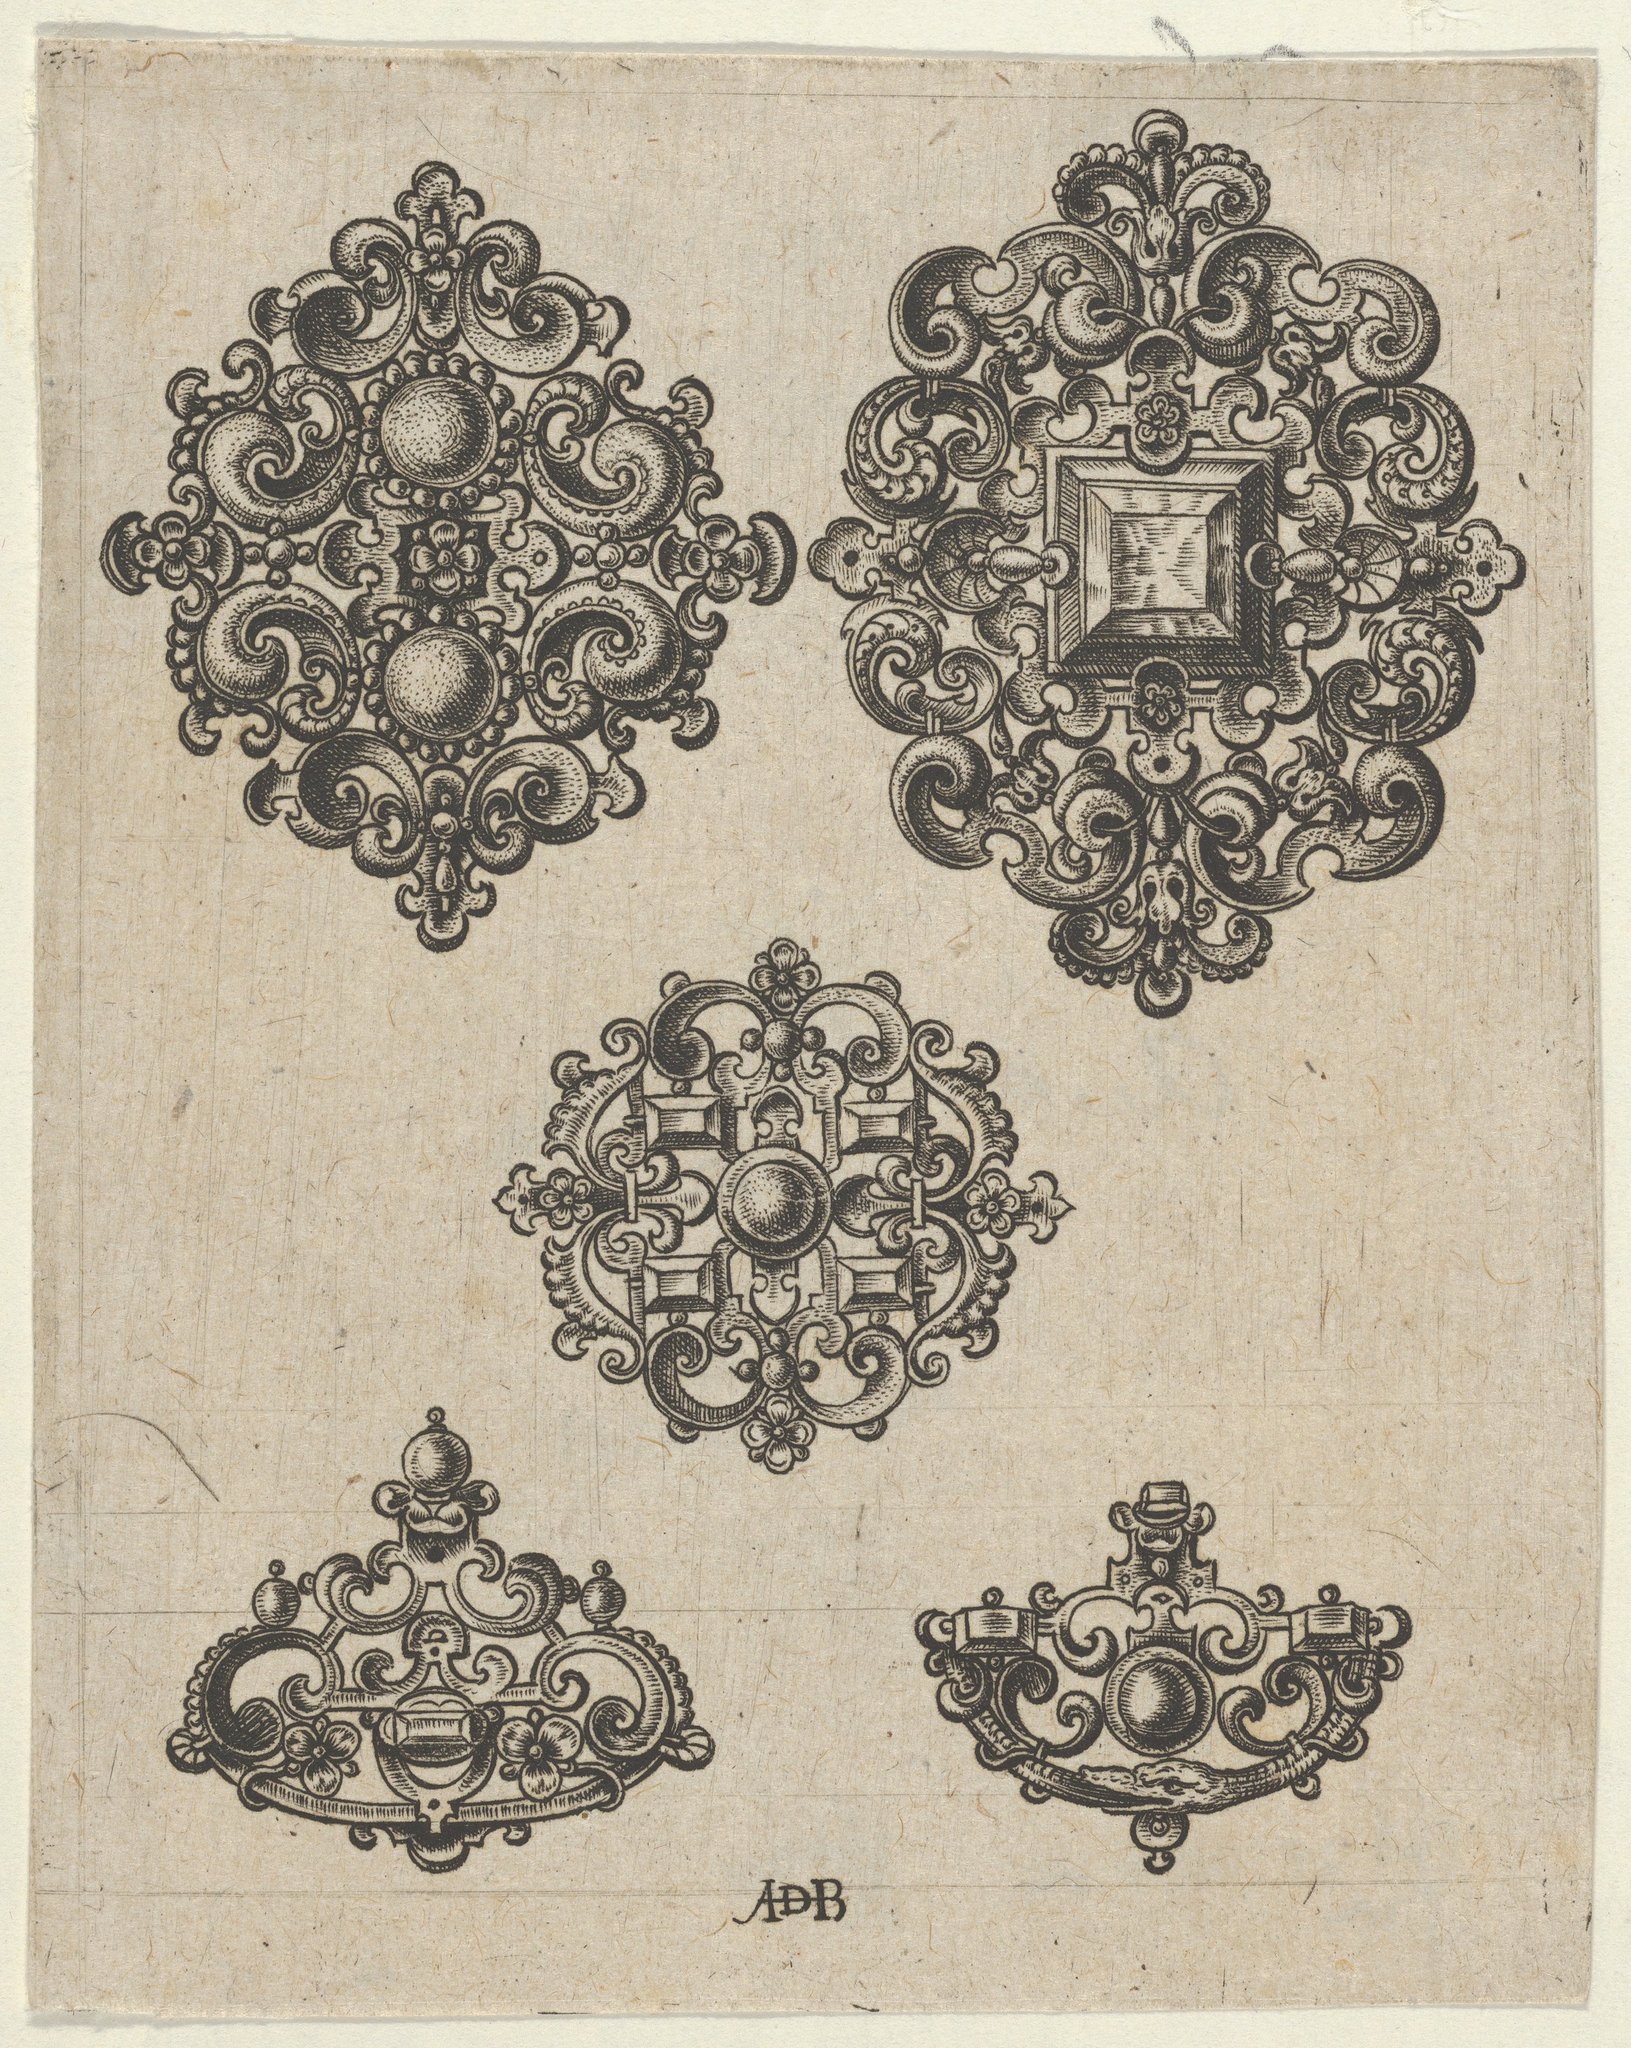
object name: print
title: Vertical Panel with Five Jewelry Motifs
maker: abraham de bruyn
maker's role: artist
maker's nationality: flemish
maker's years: 1540-1587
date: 1580-1600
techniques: engraving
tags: jewelry